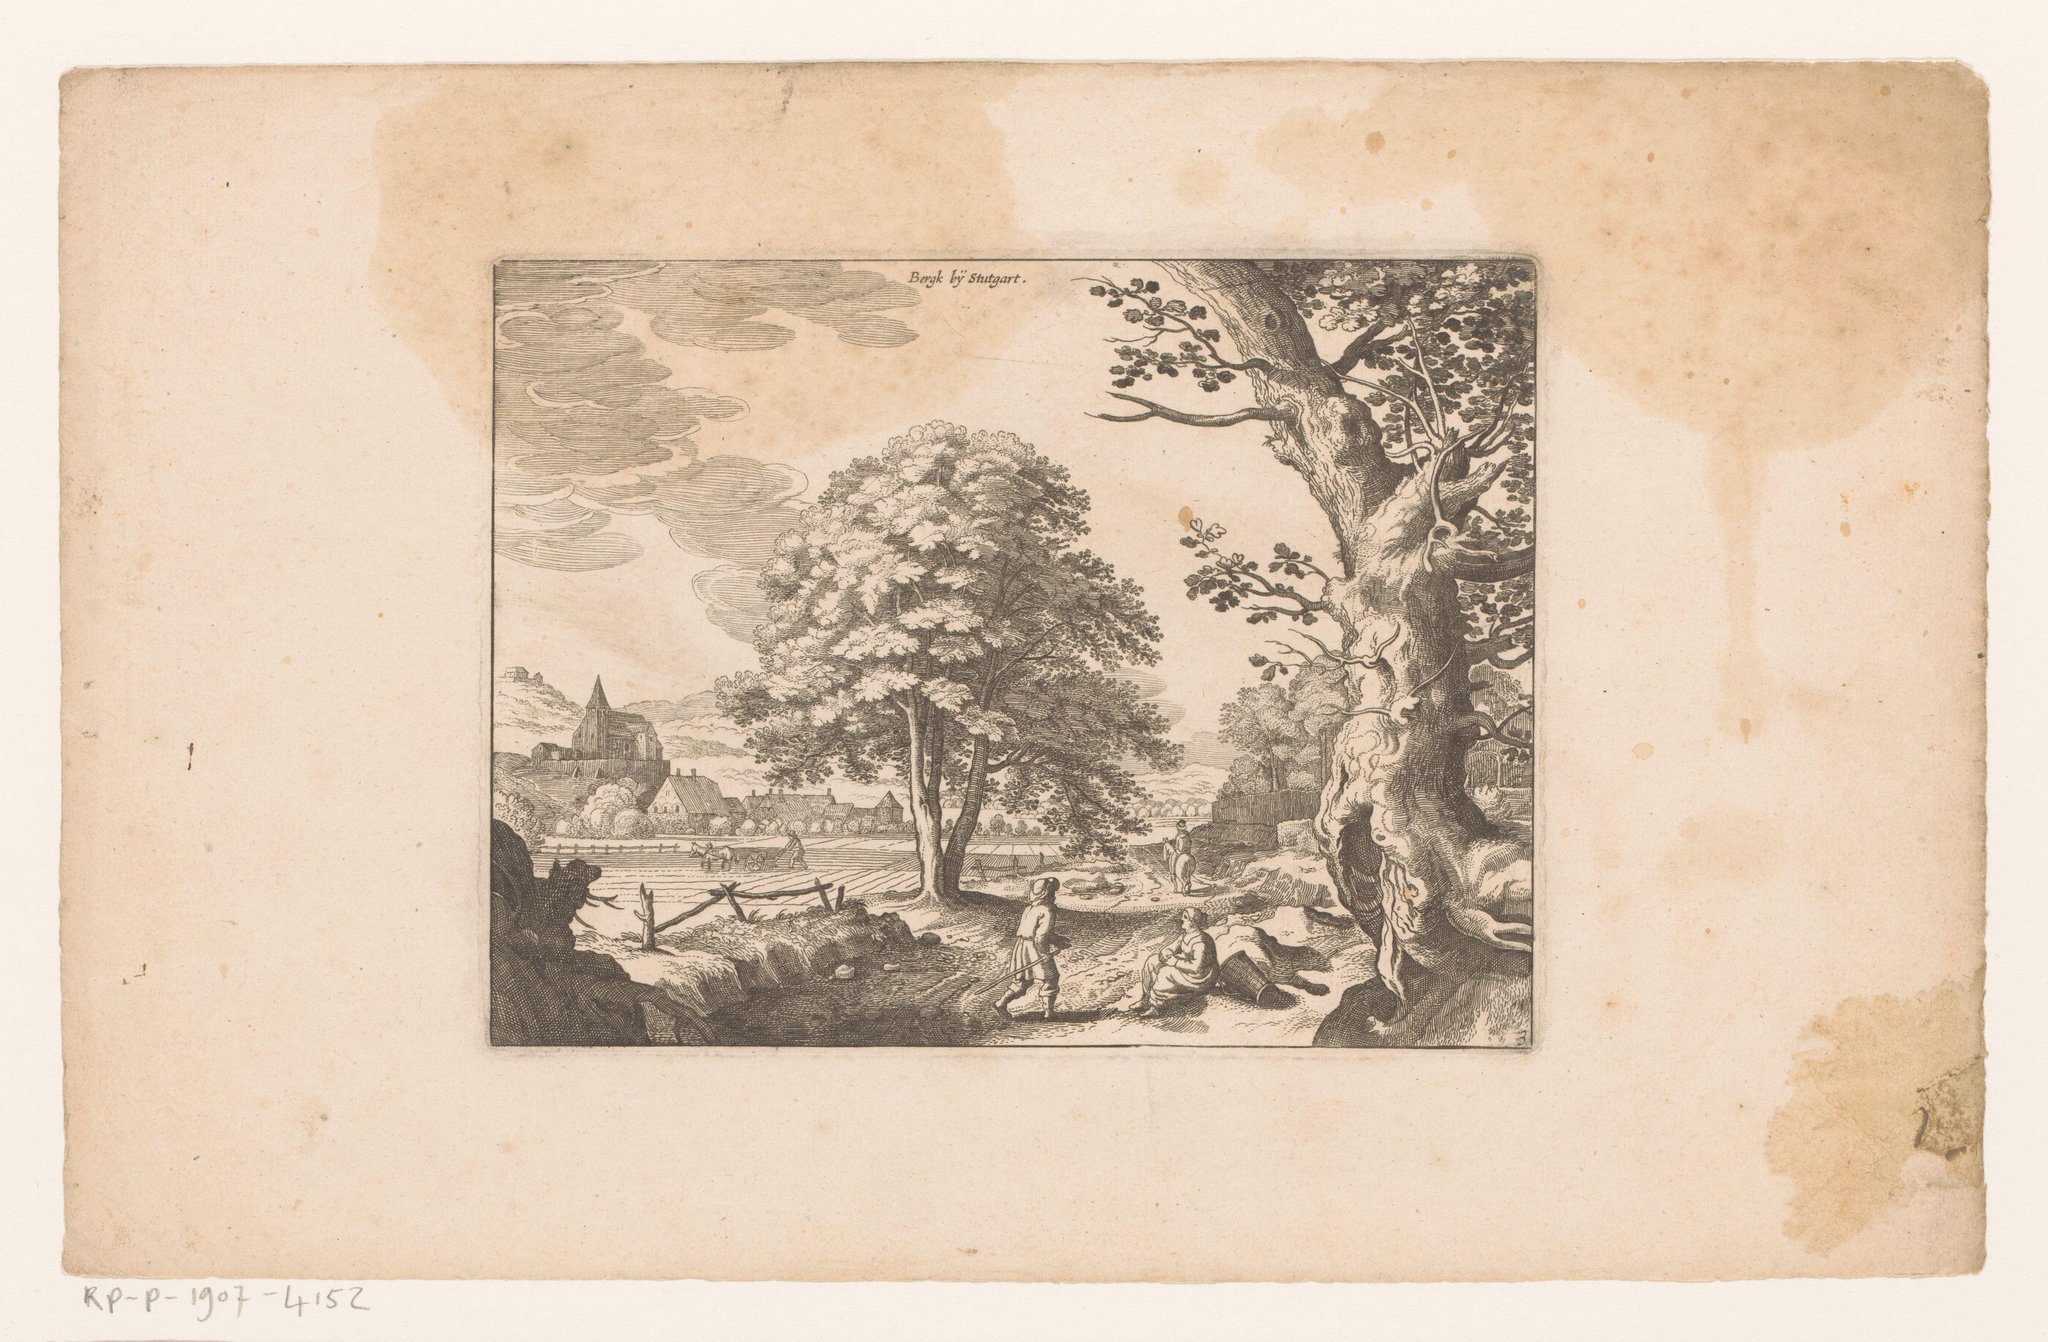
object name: print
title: Zes landschappen naar Matthäus Merian I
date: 1628-1679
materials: paper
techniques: etching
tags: city-view, and landscape with man-made constructions, ploughed field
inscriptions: collector's mark: Lugt 2228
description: Kopie in dezelfde richting naar de prent van Matthäus Merian I (Hollstein 343). Deze prent heeft nummer 3 rechtsonder gedrukt.